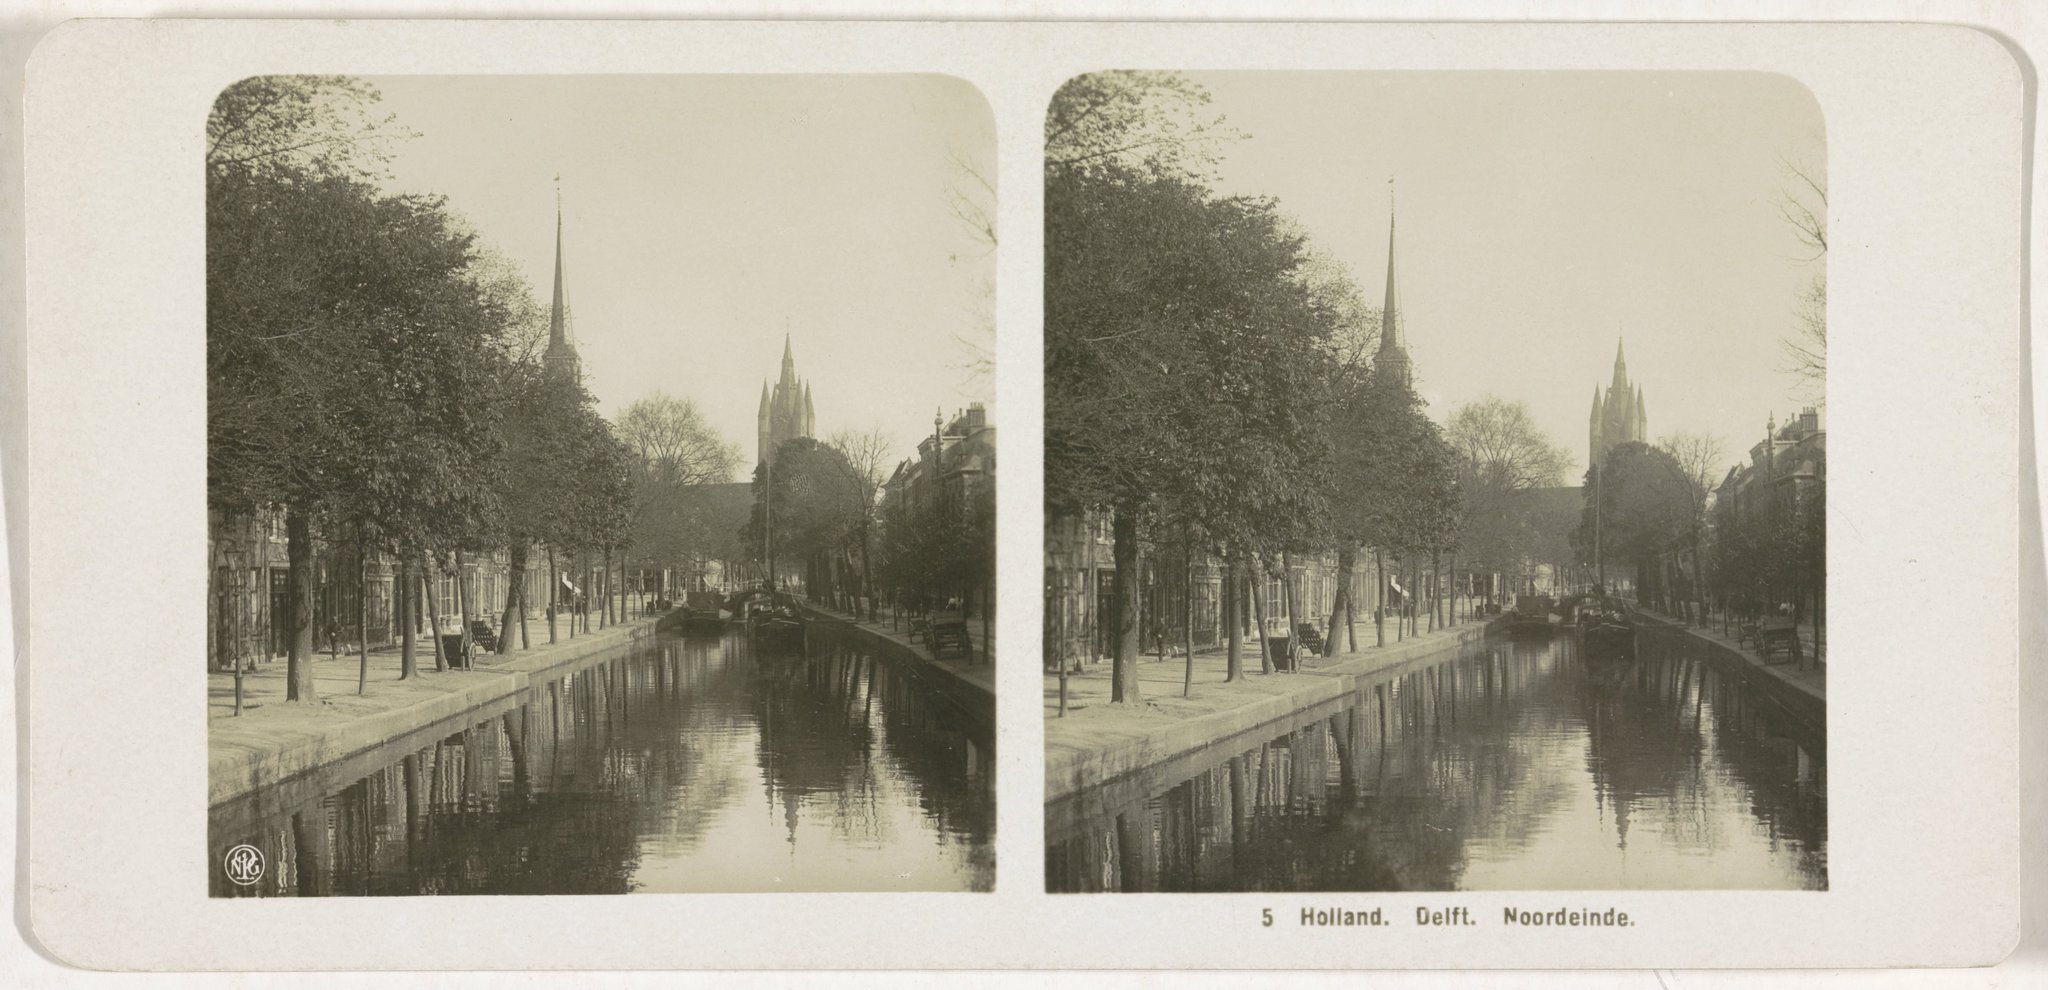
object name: stereograph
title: Noordeinde te Delft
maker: ngp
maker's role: fotograaf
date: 1900-1940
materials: cardboard, paper, photographic support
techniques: gelatin silver print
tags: delft